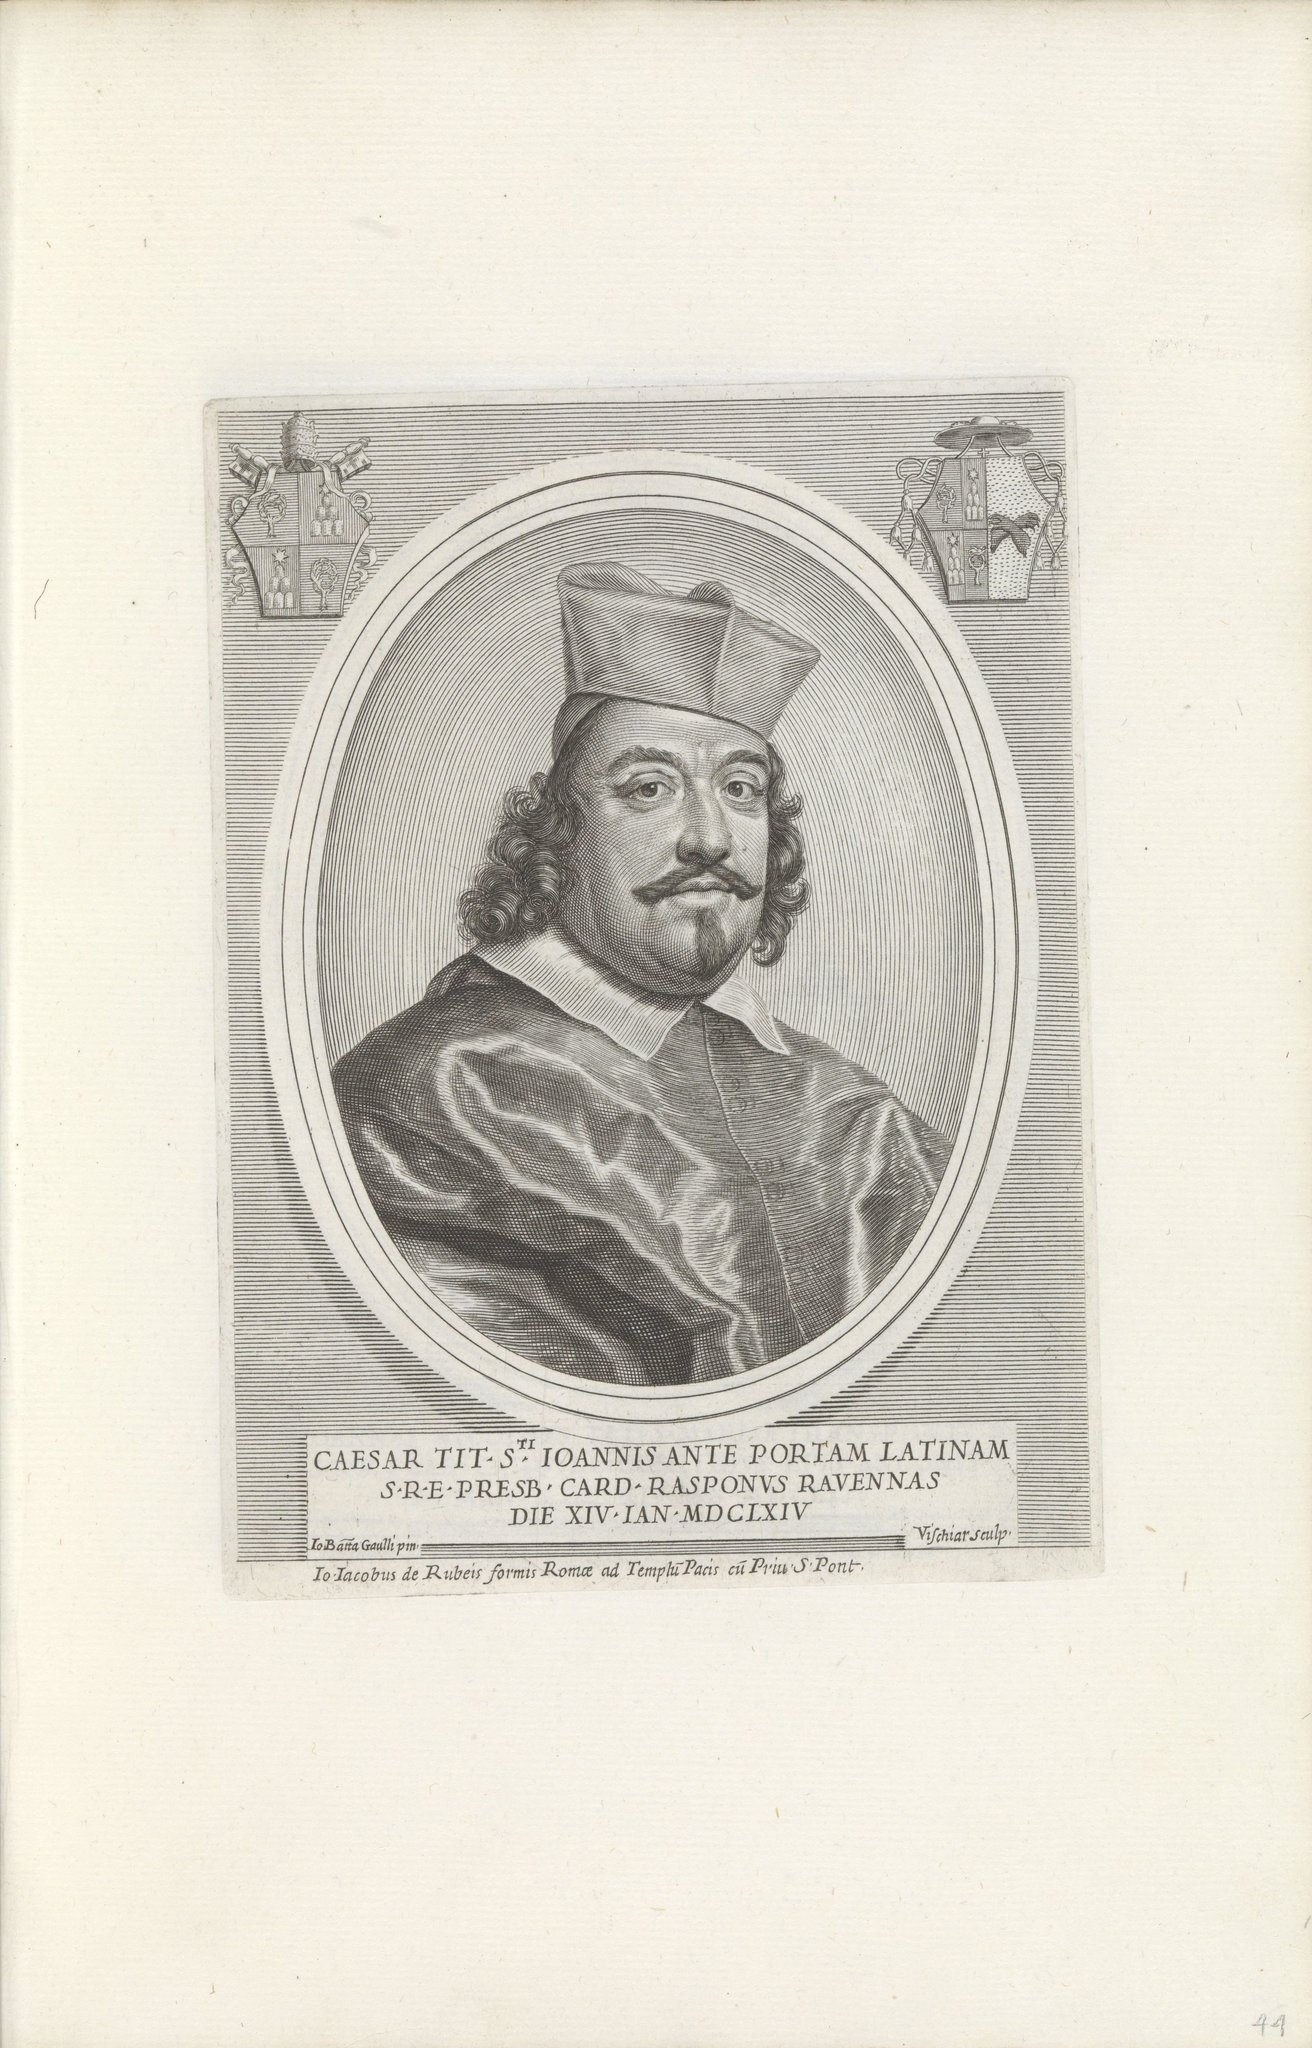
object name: print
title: Effigies Nomina et Cognomina S.D.N. Alexandri Papae VII et RR. DD. SRE. Cardd (...).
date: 1675-1690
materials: paper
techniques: engraving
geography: rome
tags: rome, cardinal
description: Portret van kardinaal Cesare Rasponi. Linksboven het wapen van paus Alexander VII en rechtsboven het wapen van de kardinaal. Onderaan een onderschrift in het Latijn. De prent maakt deel uit van een album.